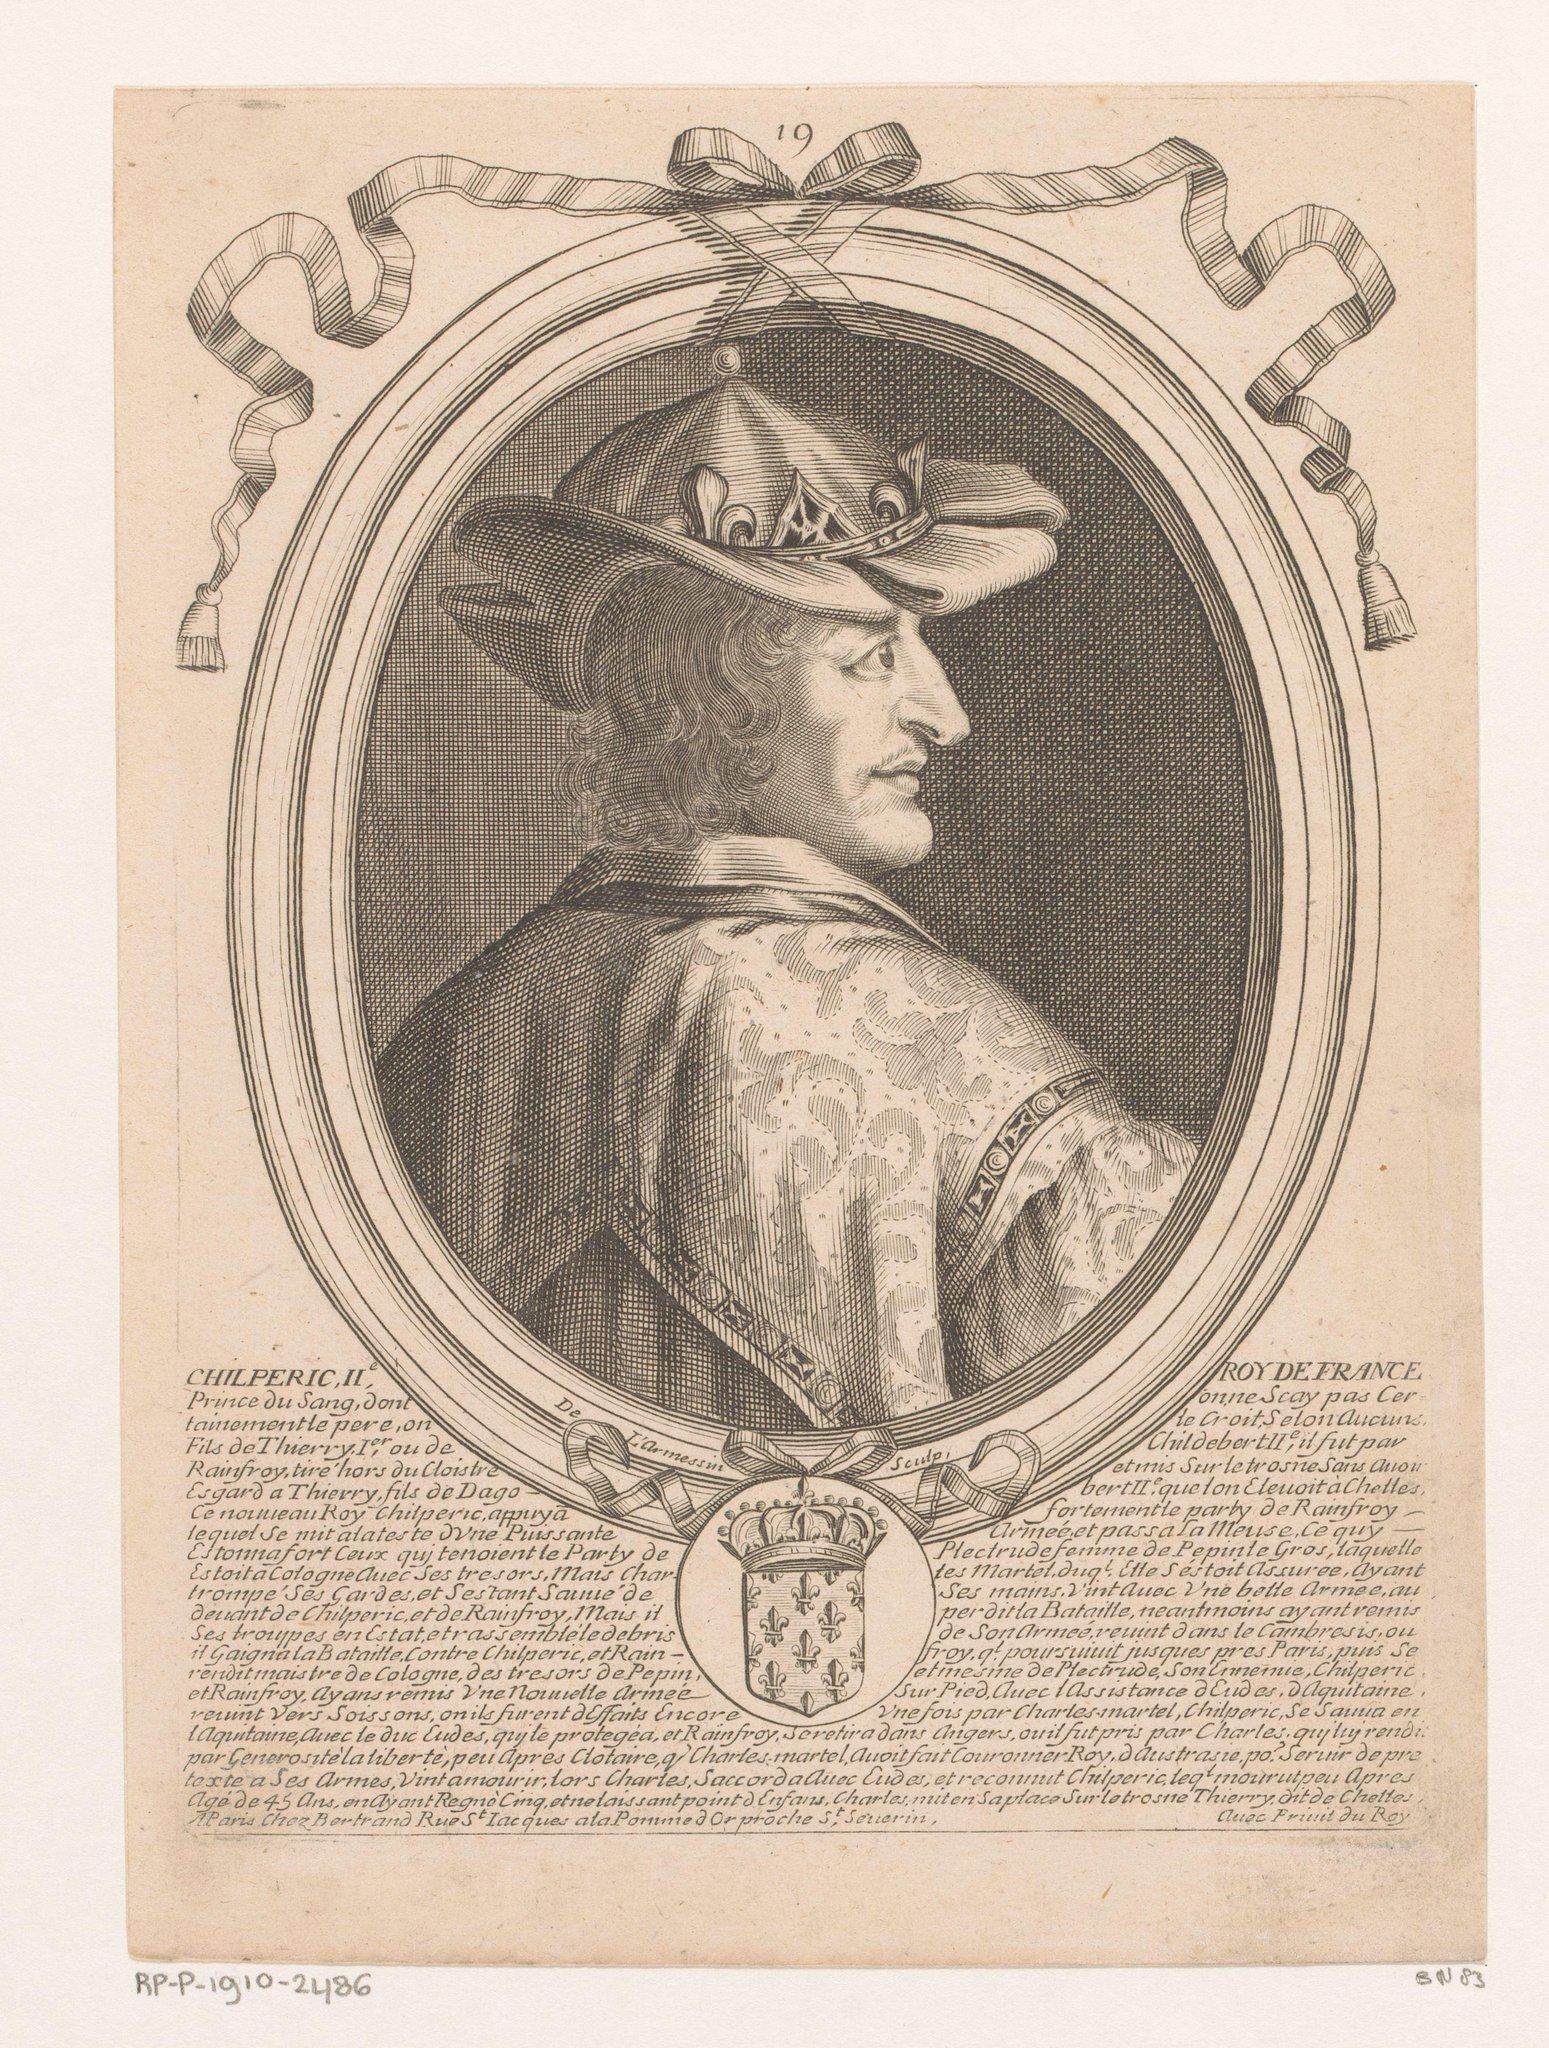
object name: print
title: Portretten van prominente figuren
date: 1647-1678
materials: paper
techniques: engraving, etching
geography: france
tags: historical persons, king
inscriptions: collector's mark: Lugt 2228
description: Maakt deel uit van een grootschalige serie met portretten van prominente figuren. Binnen de serie bevindt zich een sectie getiteld 'Les Augustes Représentations De tous les Roys De France depuis Pharamond Iusqu'à Louys XIIII'. De serie werd respectievelijk uitgegeven door Pierre Bertrand, door zijn weduwe en door De Larmessin zelf.